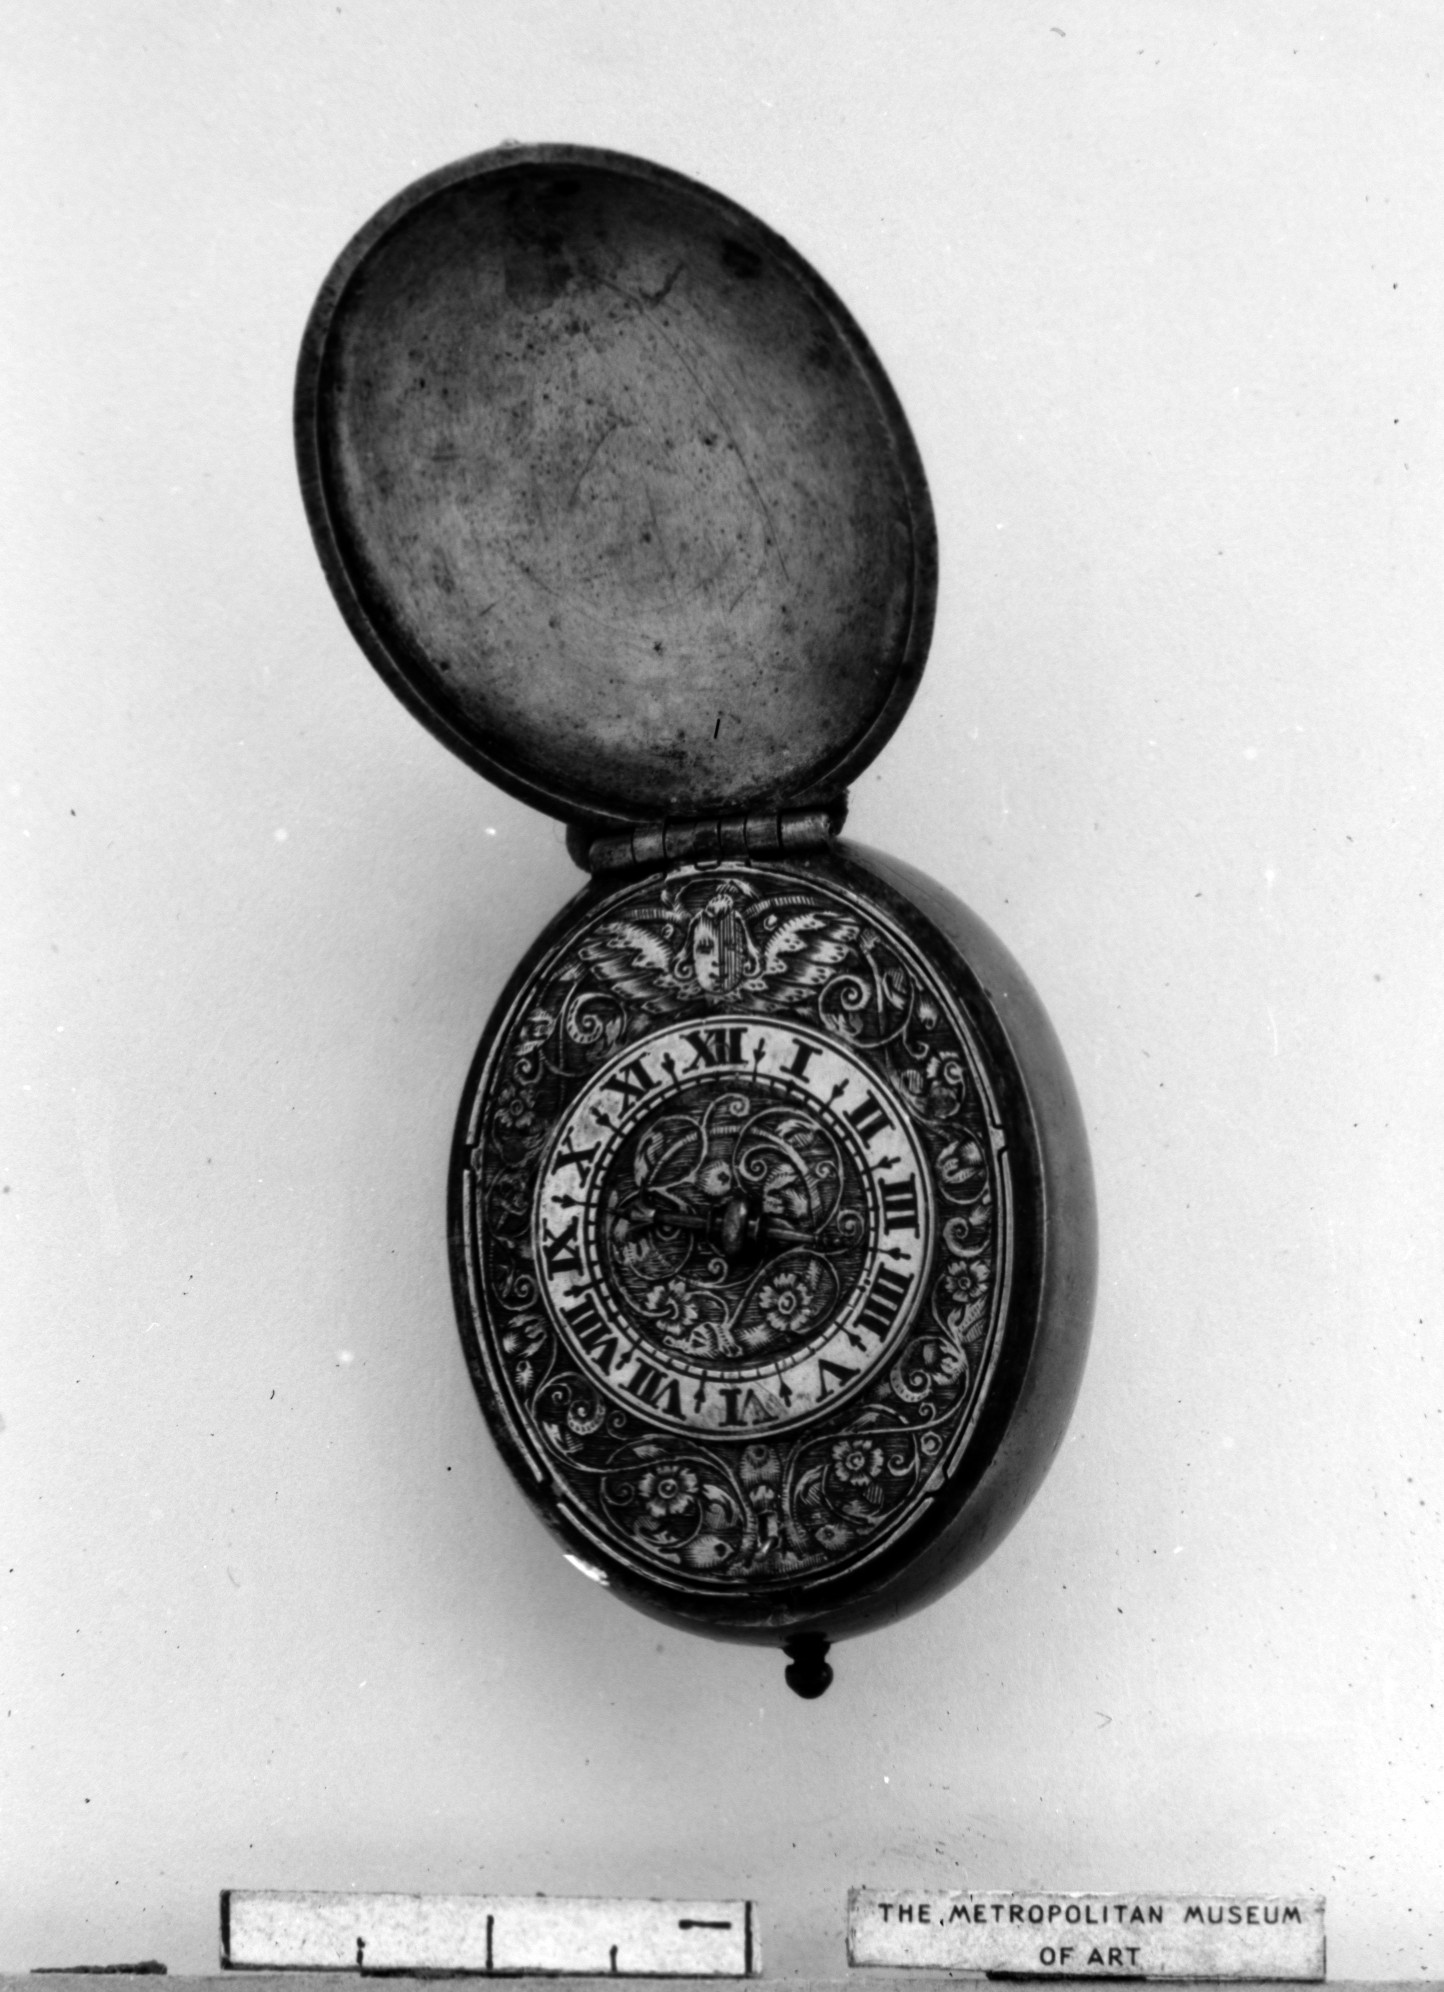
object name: pin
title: Cloak Pin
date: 1770-1800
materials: brass, enamel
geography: england